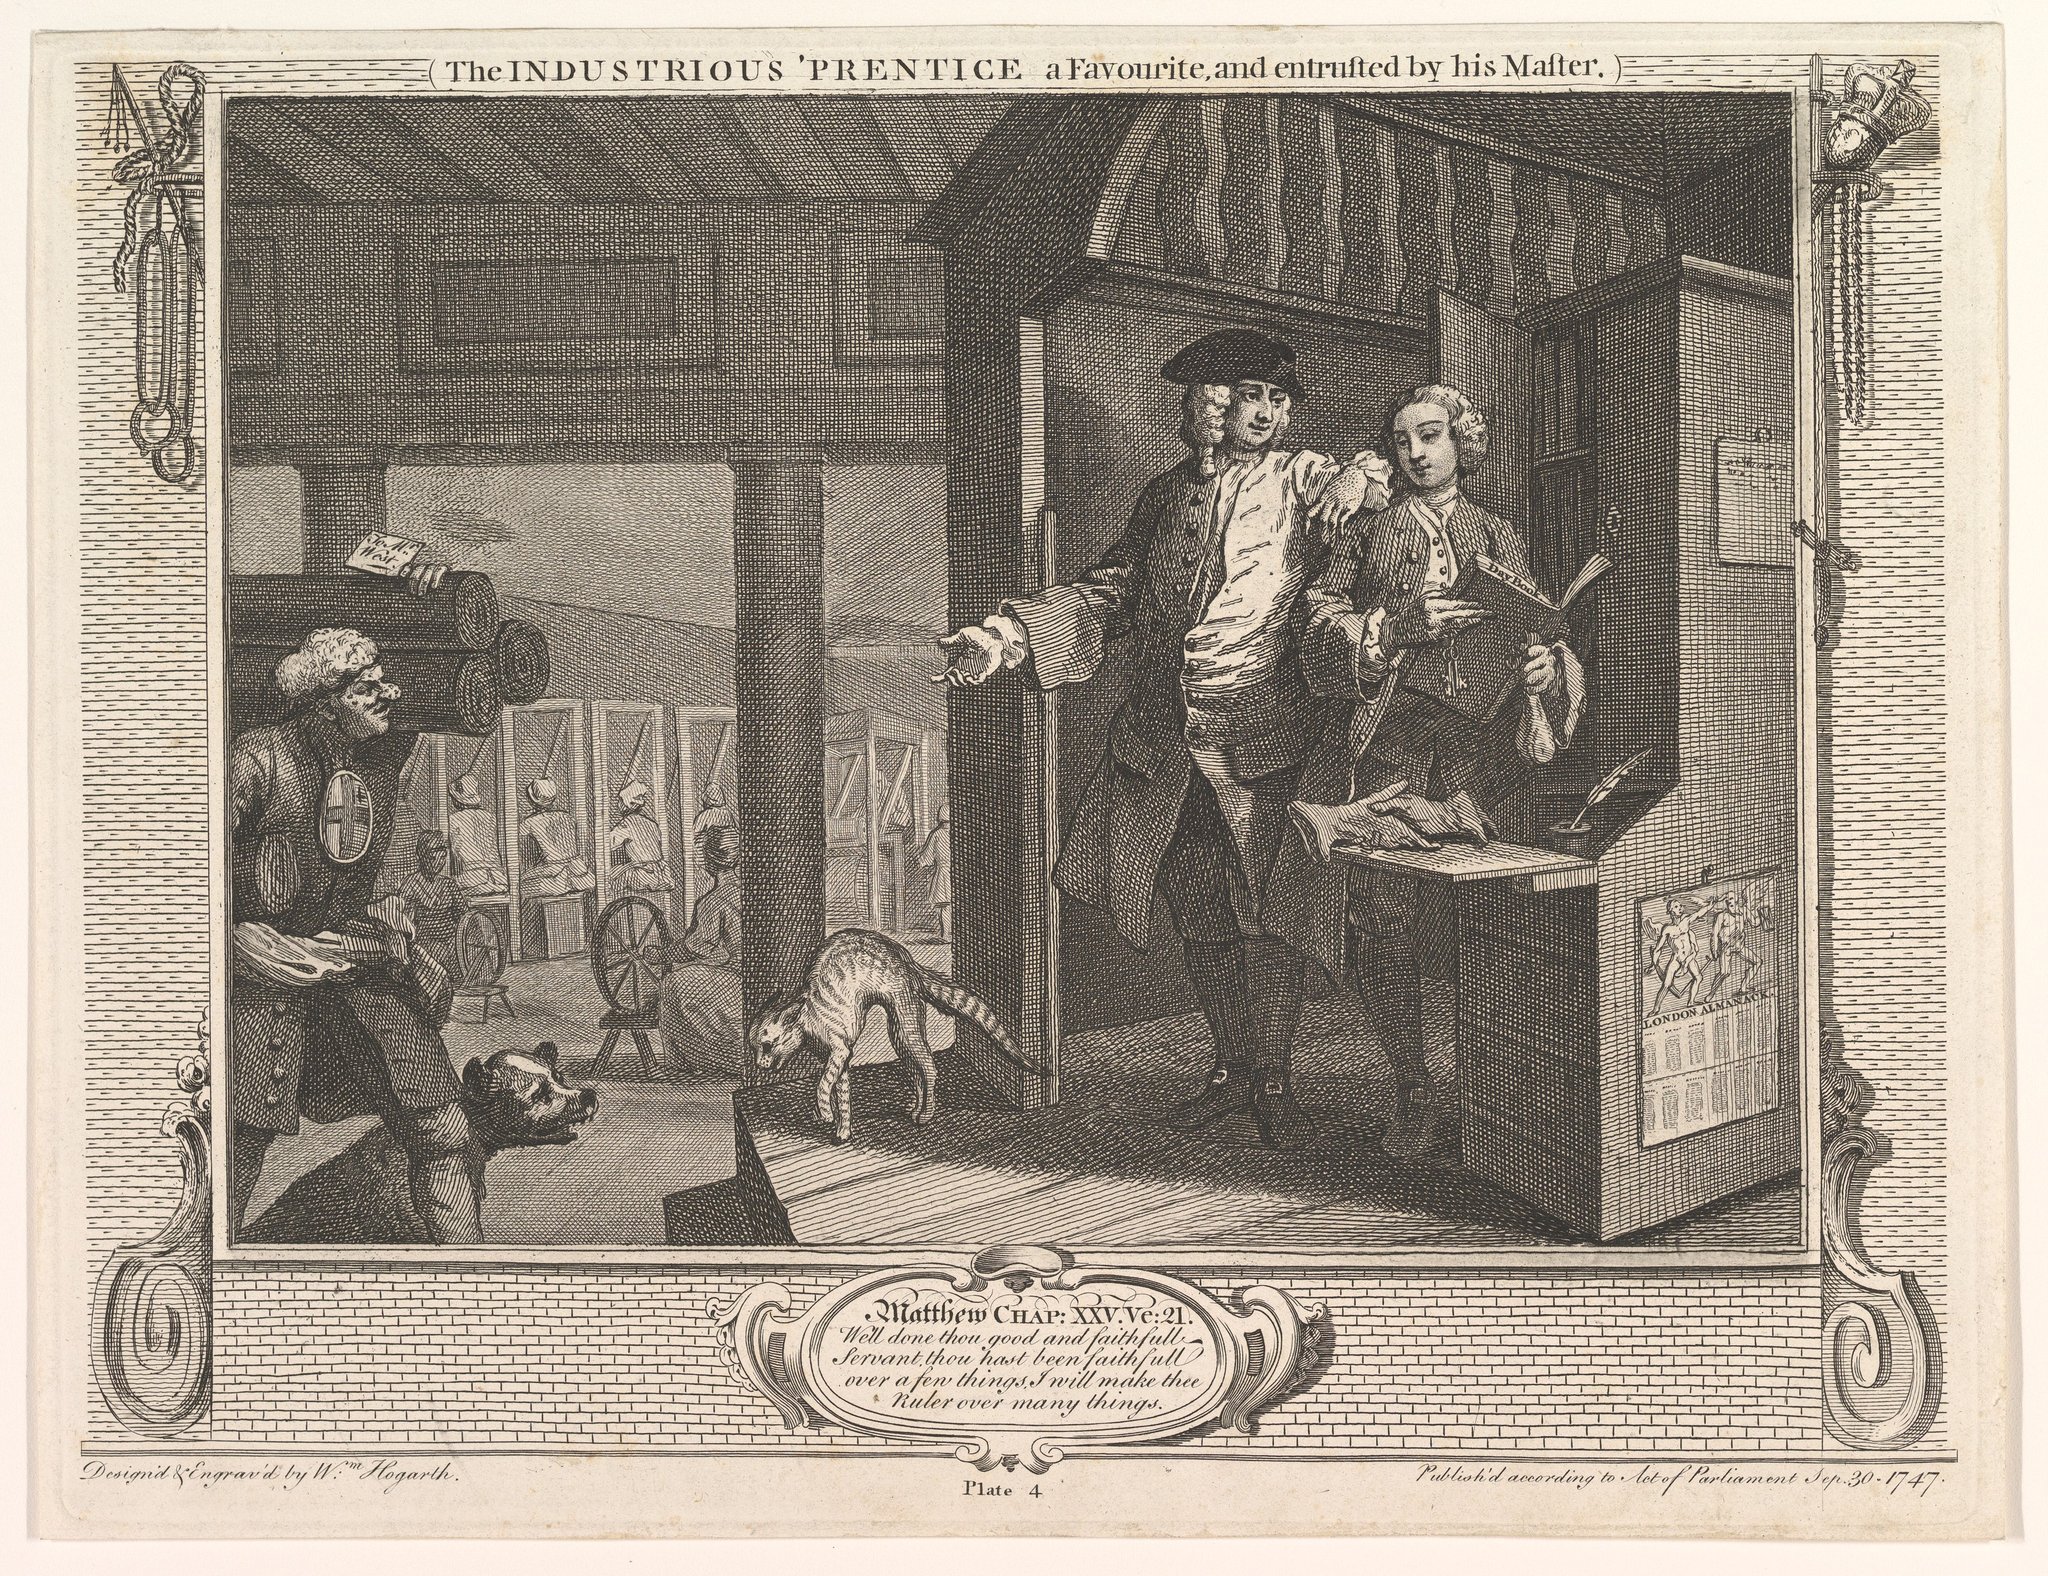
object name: print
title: The Industrious 'Prentice a Favorite and Entrusted by his Master (Industry and Idleness, plate 4)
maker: william hogarth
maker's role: artist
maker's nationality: british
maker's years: 1697-1764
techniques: engraving, etching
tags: men,women,cats,dogs,working